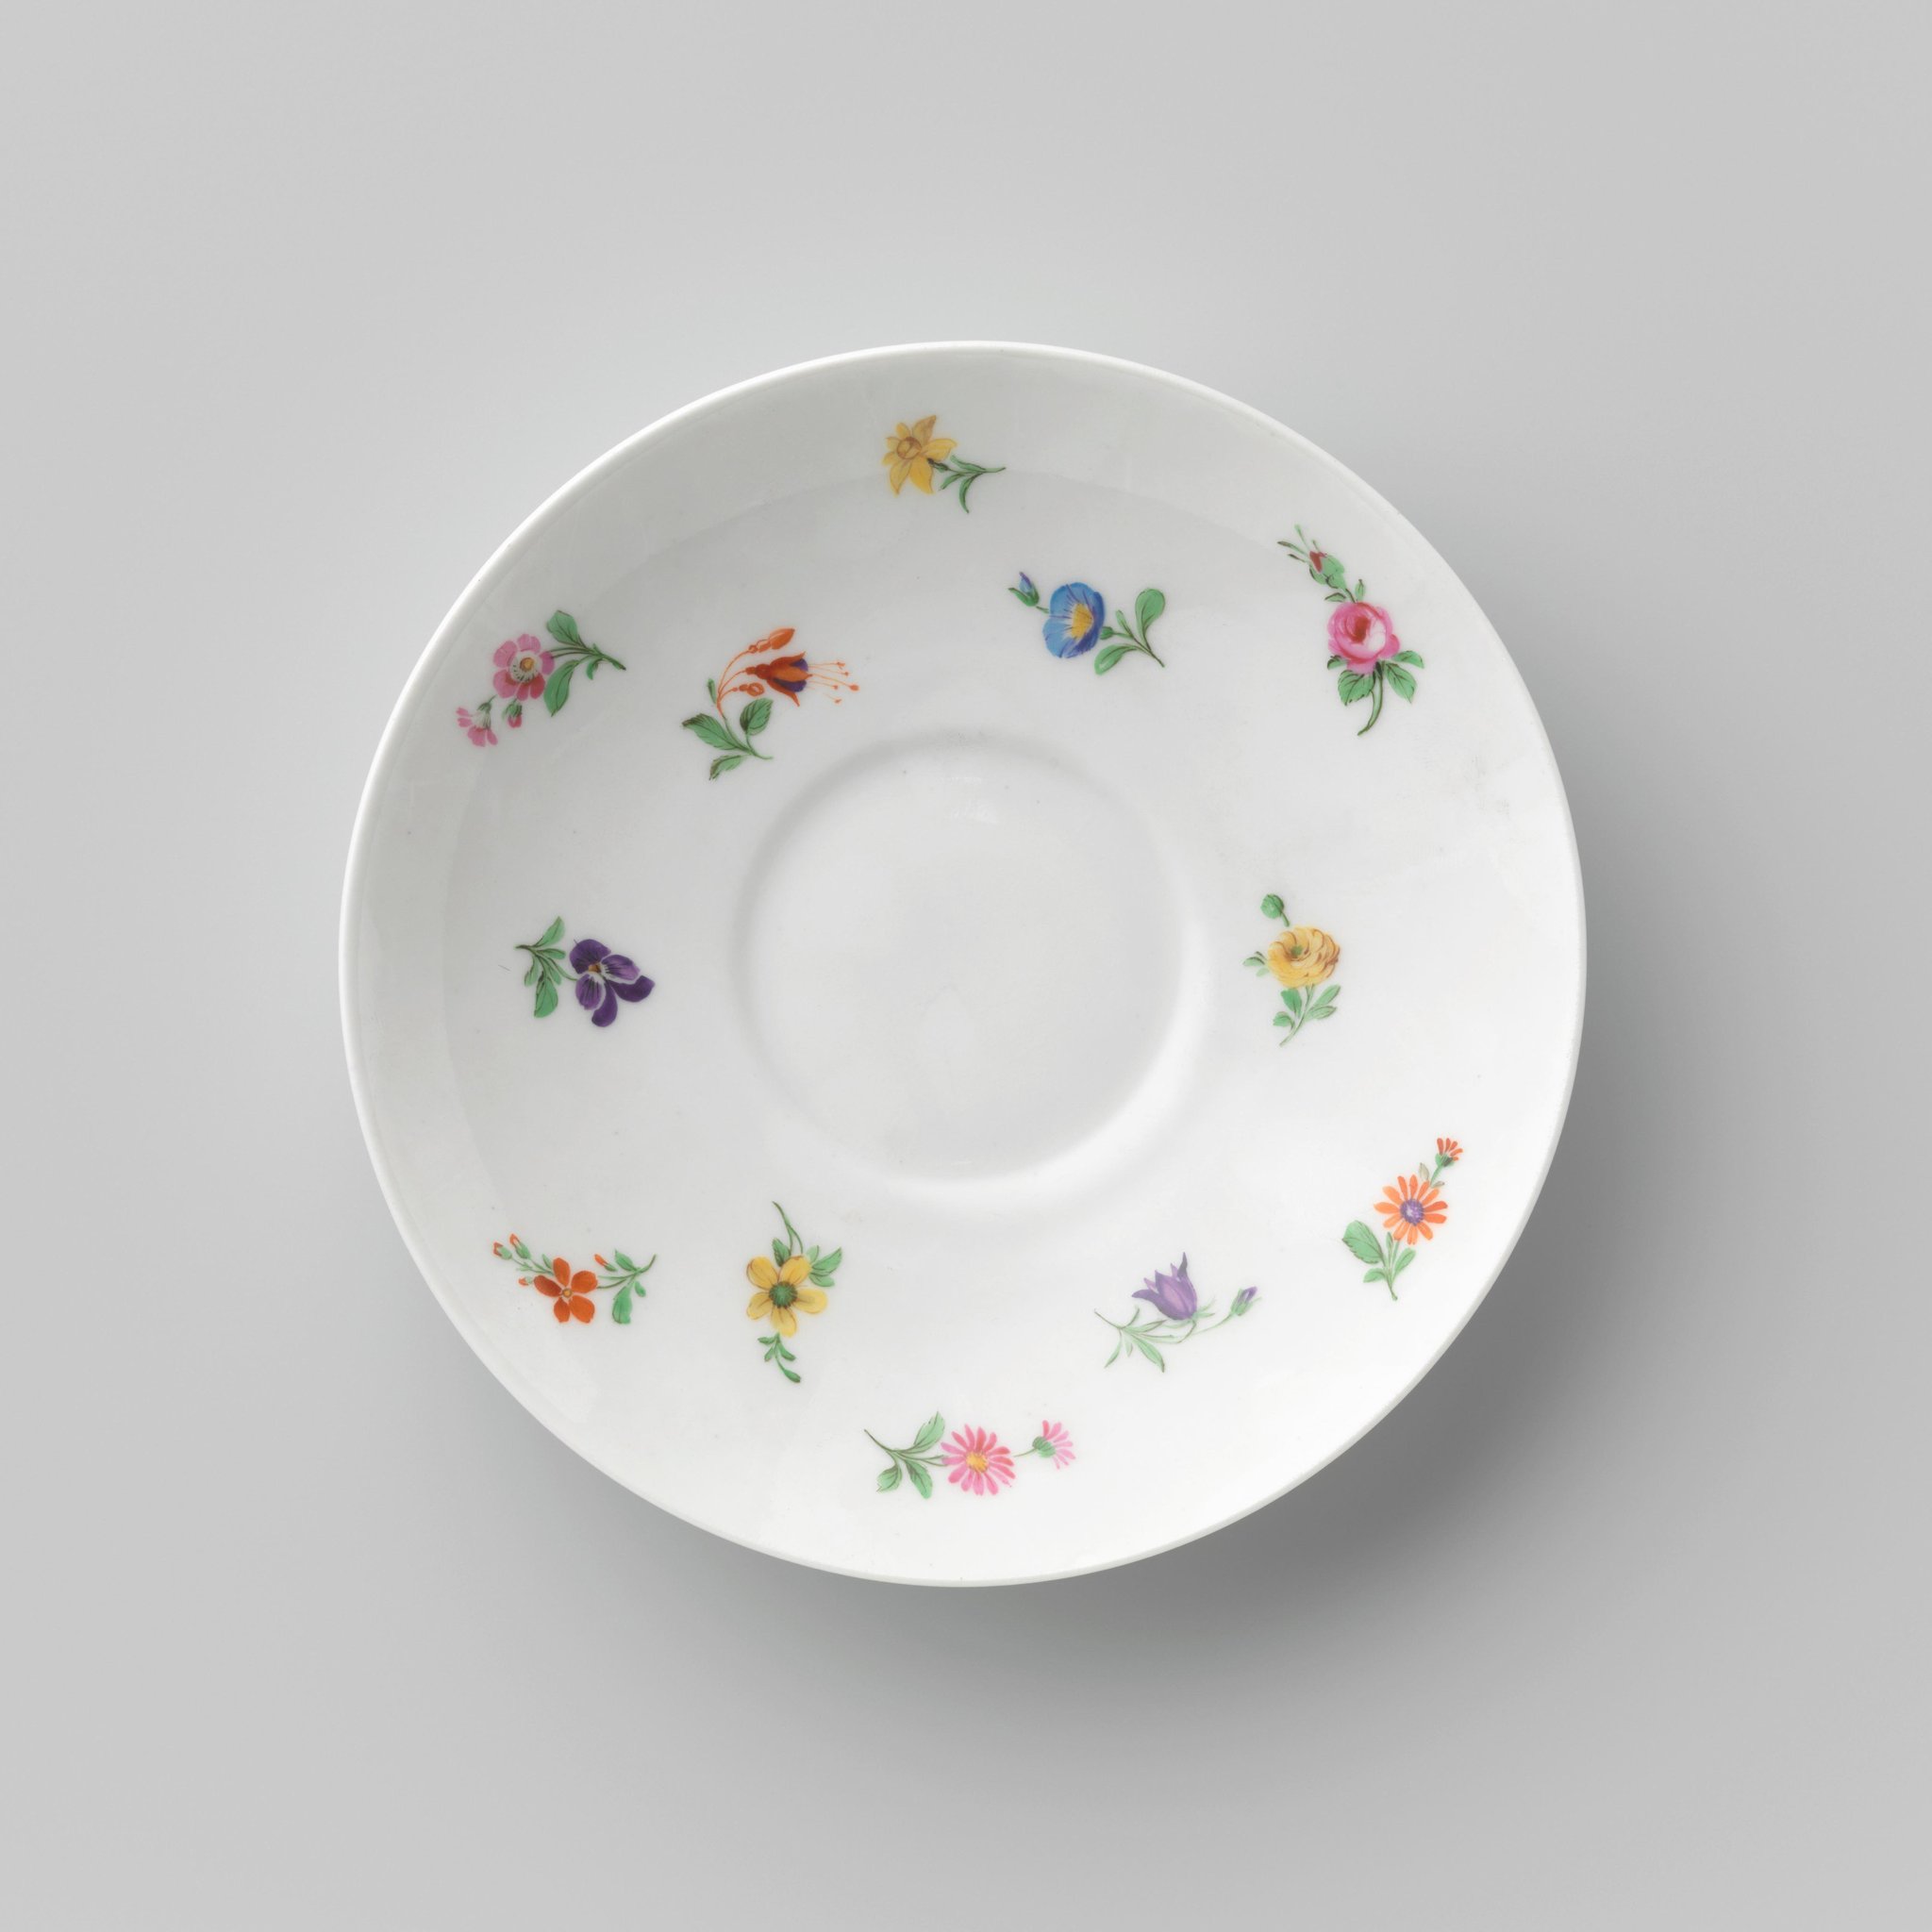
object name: platter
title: Saucer with flowers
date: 1913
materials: glaze, paint, porcelain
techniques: firing, turning, vitrification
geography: berlin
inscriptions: mark: ‘scepter/ rode rijksappel met K.P.M/ N(1913)/ I’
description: Schotel van porselein met veelkleurig strooibloempatroon. Deel van een serie van acht koppen en schotels. Gemerkt: drie schotels met de scepter, vier met de scepter en cirkelvormig stempel en één met de scepter en KPM, alles in onderglazuur blauw; alle schotels hebben de rijksappel met KPM in rood: ingegrift: cijfer 3 met cijfer 1 eronder, of de letter N met een 1 eronder en één maal de letter A (?) met een 1 eronder.